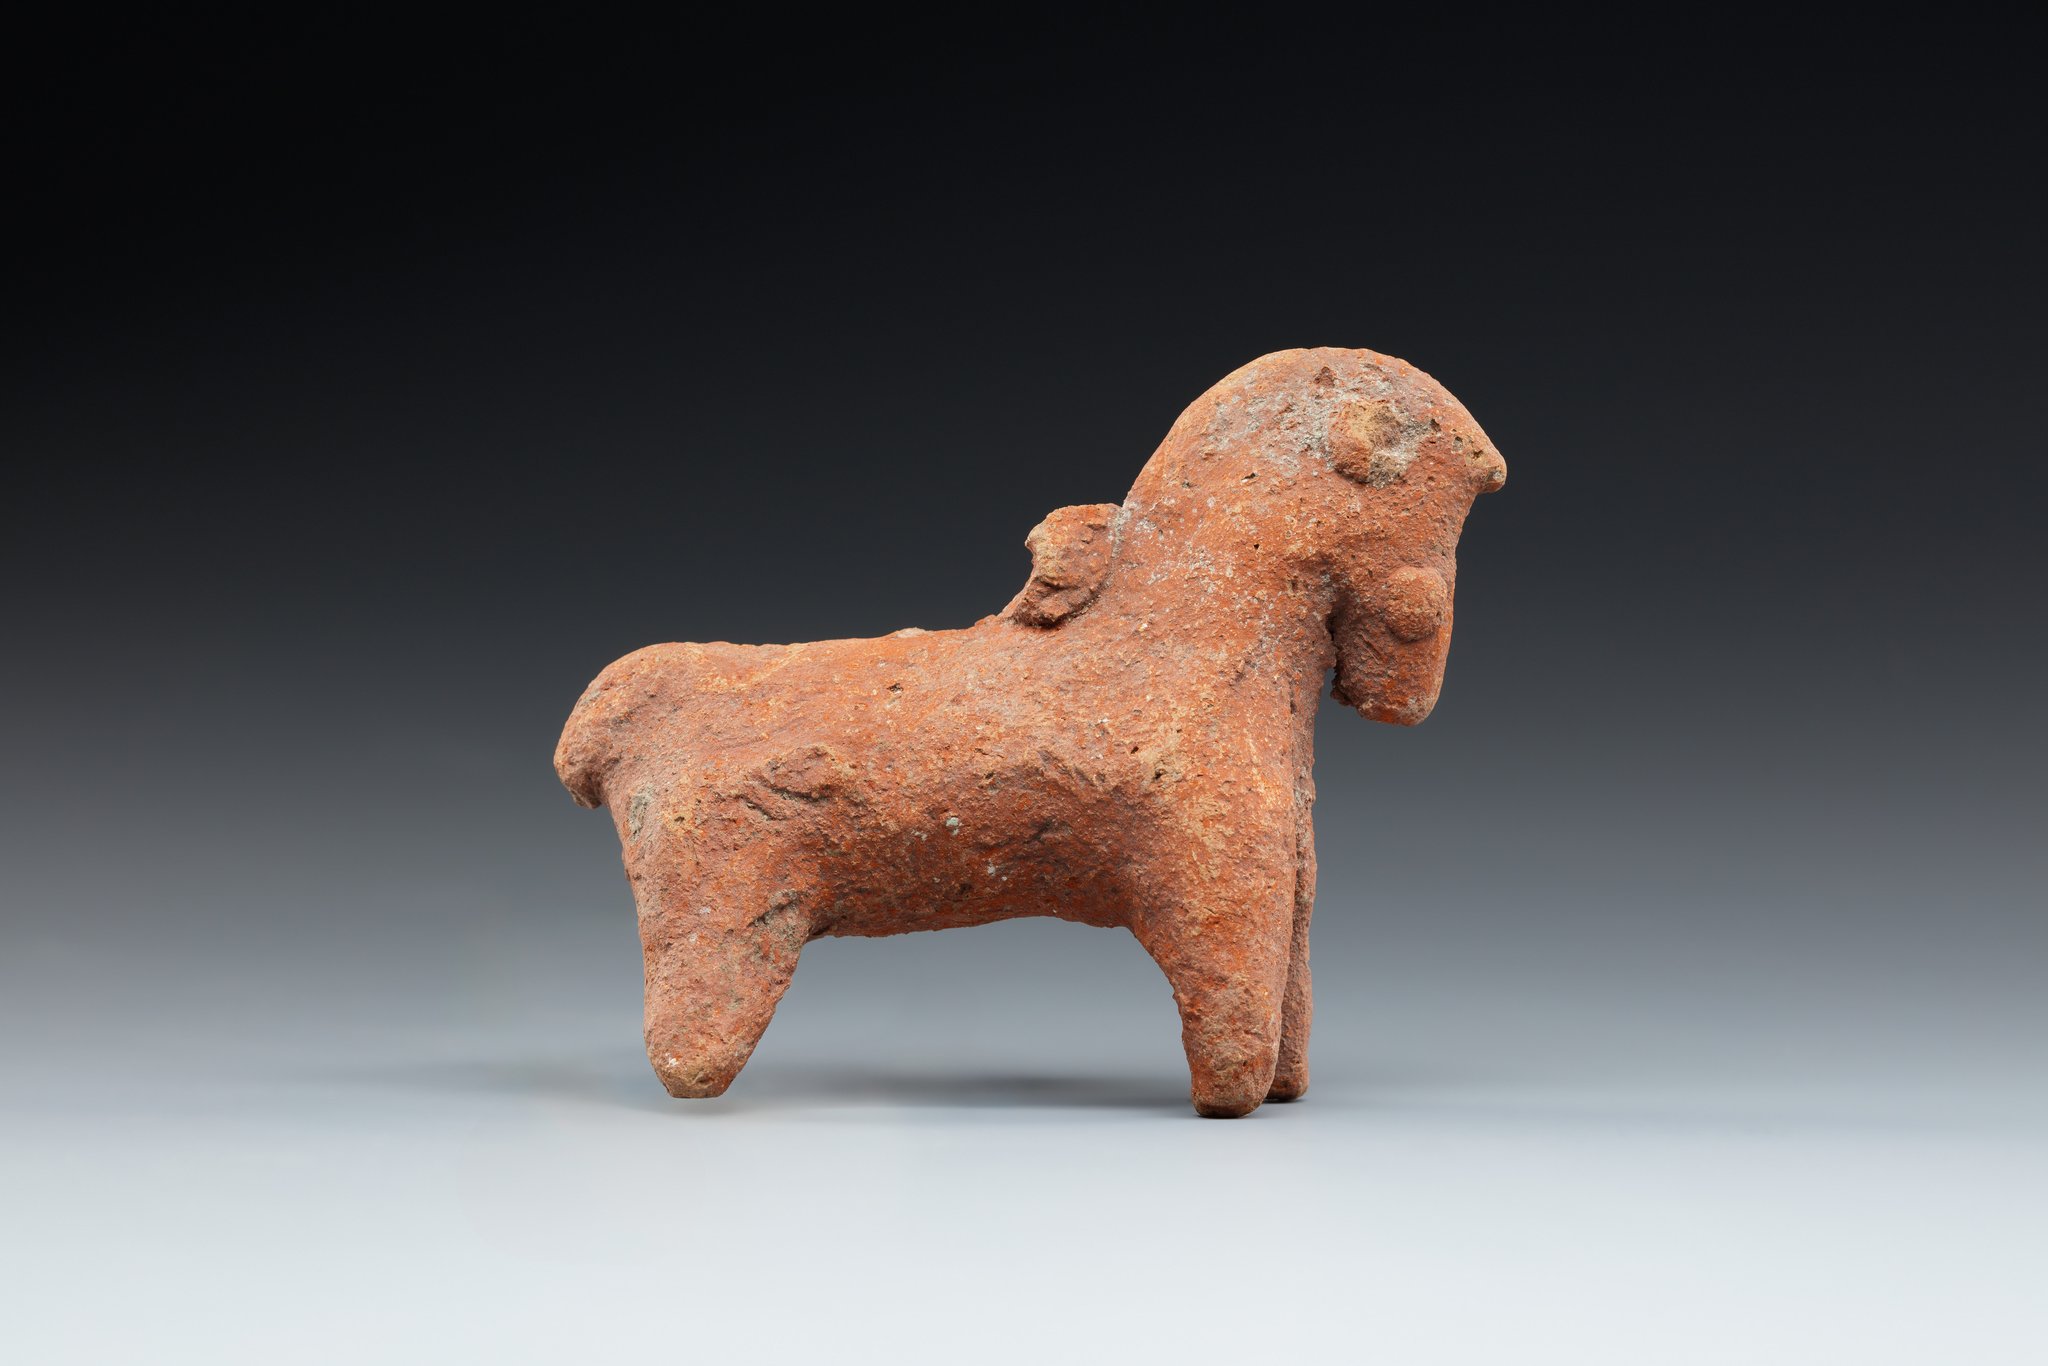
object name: figurine, horse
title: Figurine of a horse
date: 306-30 BCE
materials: pottery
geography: egypt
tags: horses